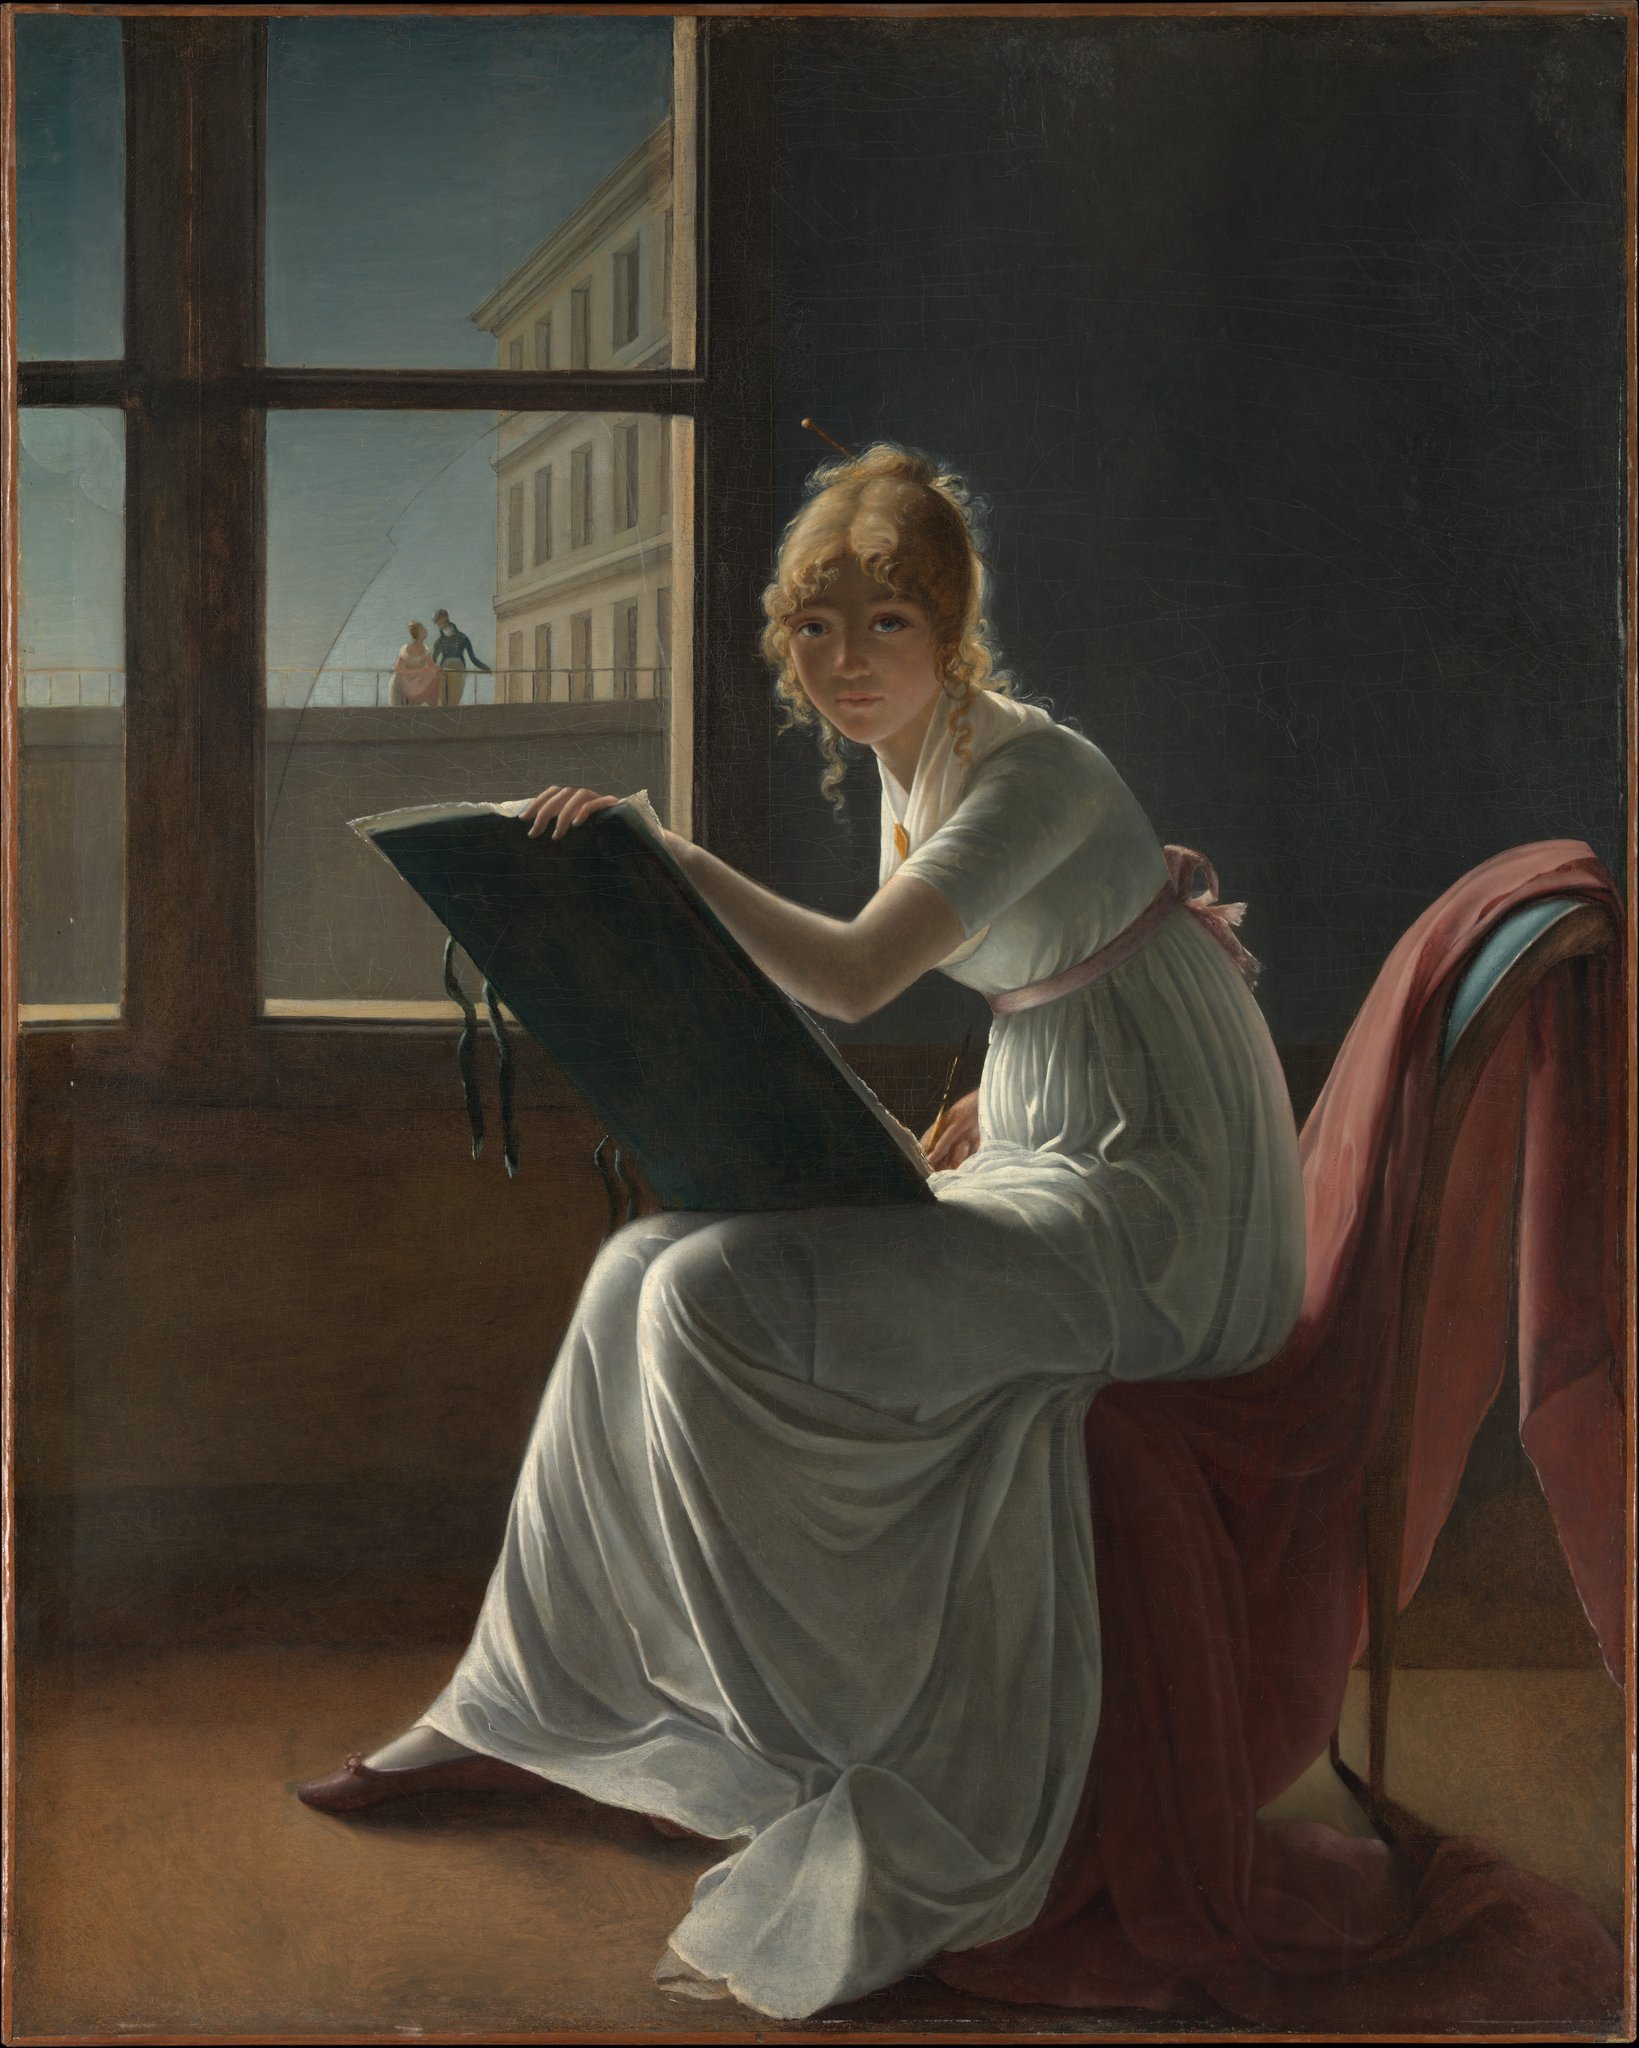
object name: painting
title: Marie Joséphine Charlotte du Val d'Ognes (1786–1868)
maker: marie denise villers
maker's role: artist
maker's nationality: french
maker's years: 1774-1821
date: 1801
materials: canvas, oil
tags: portraits,women,artists